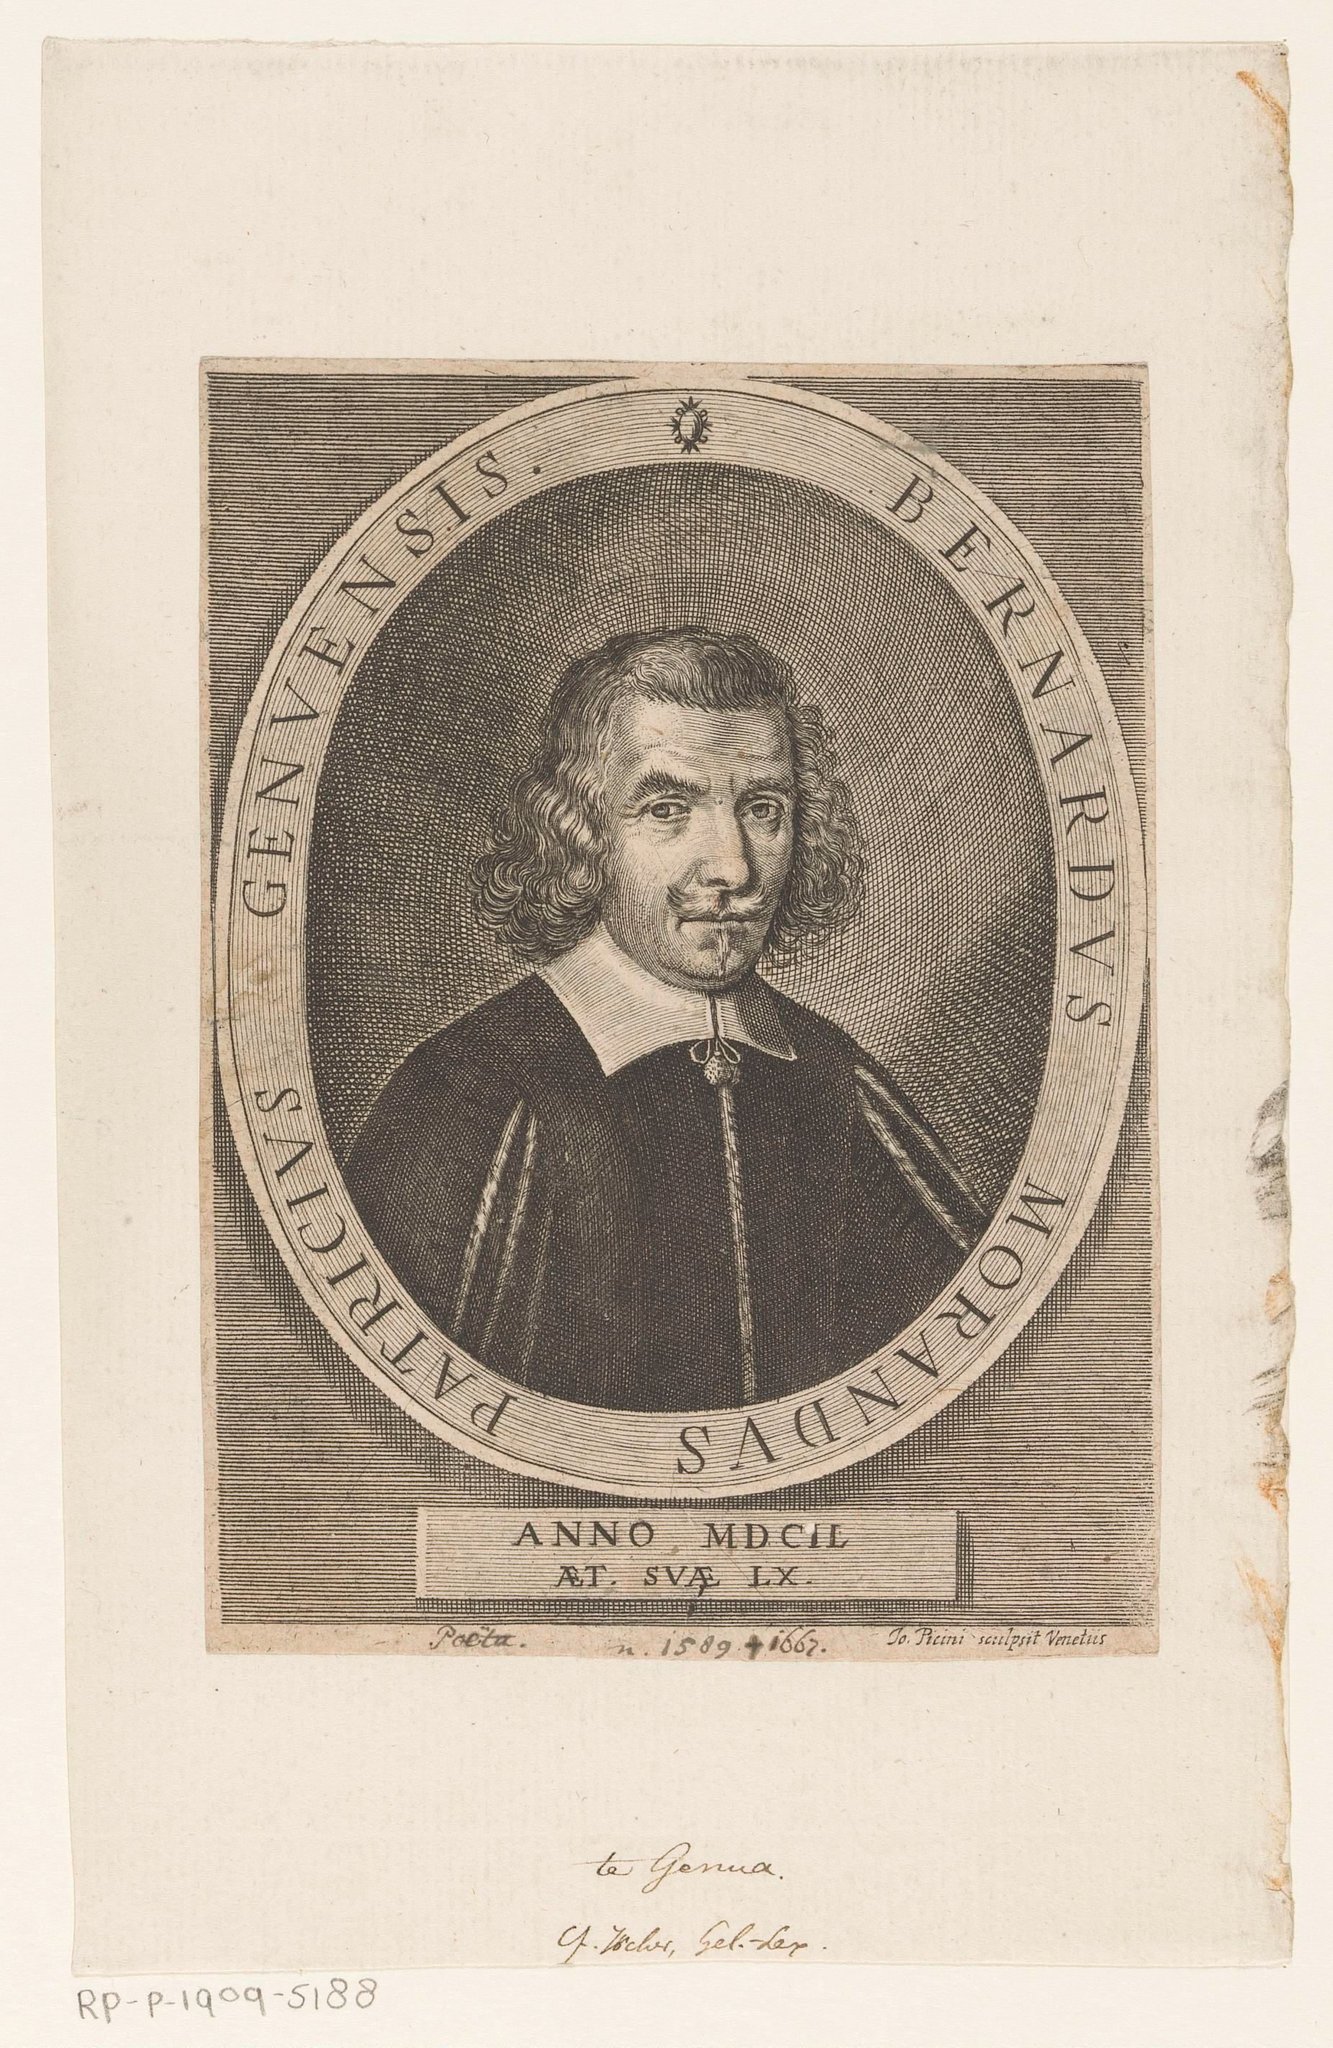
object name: print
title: Portret van dichter Bernardo Morando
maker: giacomo piccini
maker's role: print maker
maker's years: 1617-1669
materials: paper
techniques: engraving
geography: venice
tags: historical persons, writer, poet, author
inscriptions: inscription: ‘Poëta n. 1589 - 1667.’, collector's mark: Lugt 2228